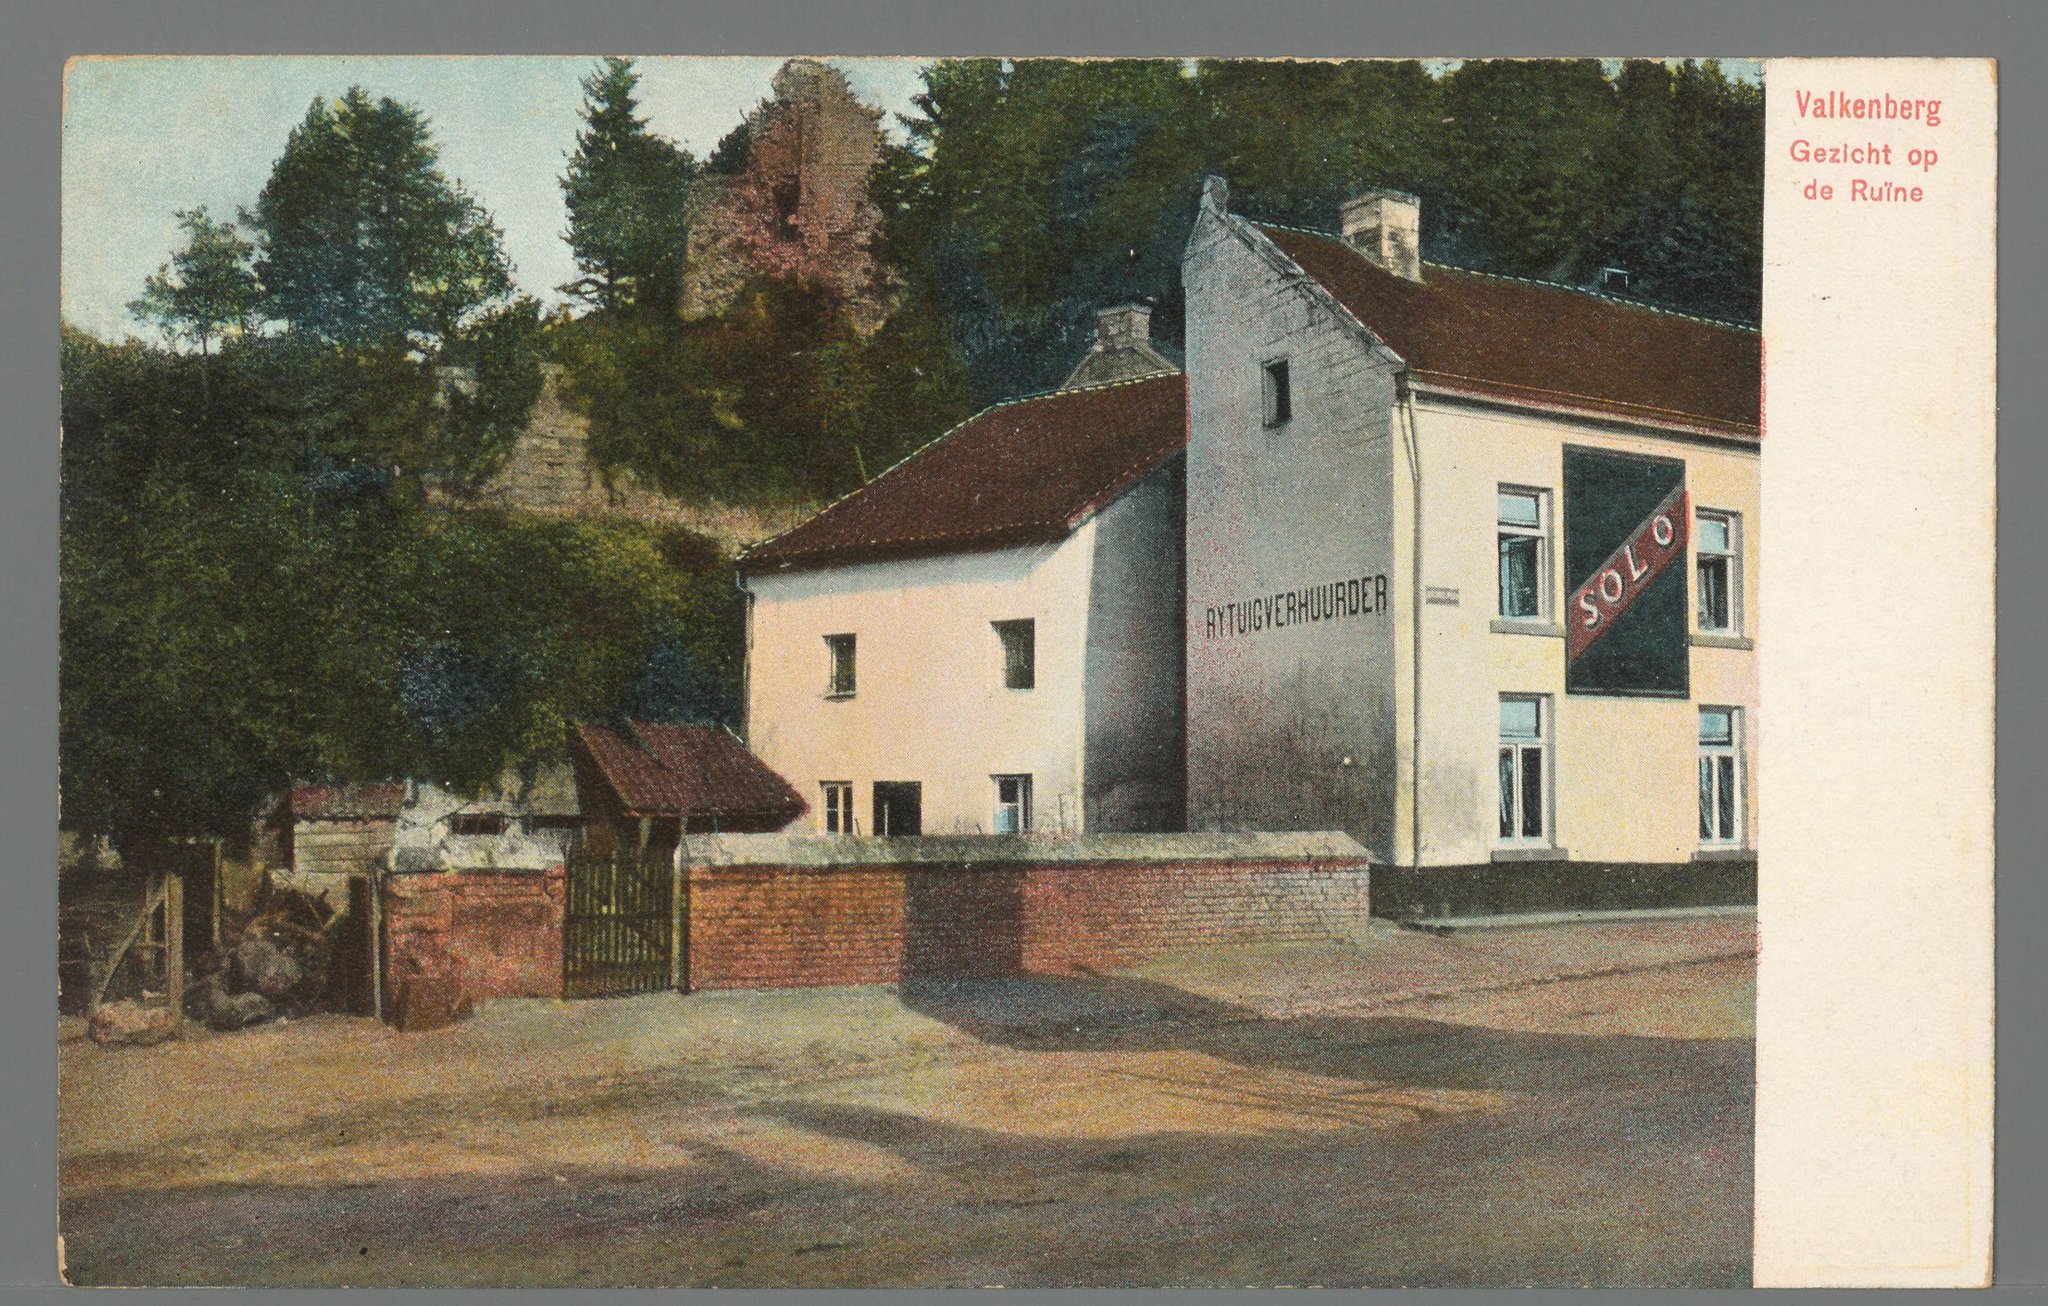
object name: ansichtkaart, prentbriefkaart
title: Valkenberg. Gezicht op de Ruïne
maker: Anonymous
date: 1905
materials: cardboard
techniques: lithograph, writing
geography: leipzig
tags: ruin of a dwelling, house, castle, etc.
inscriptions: date